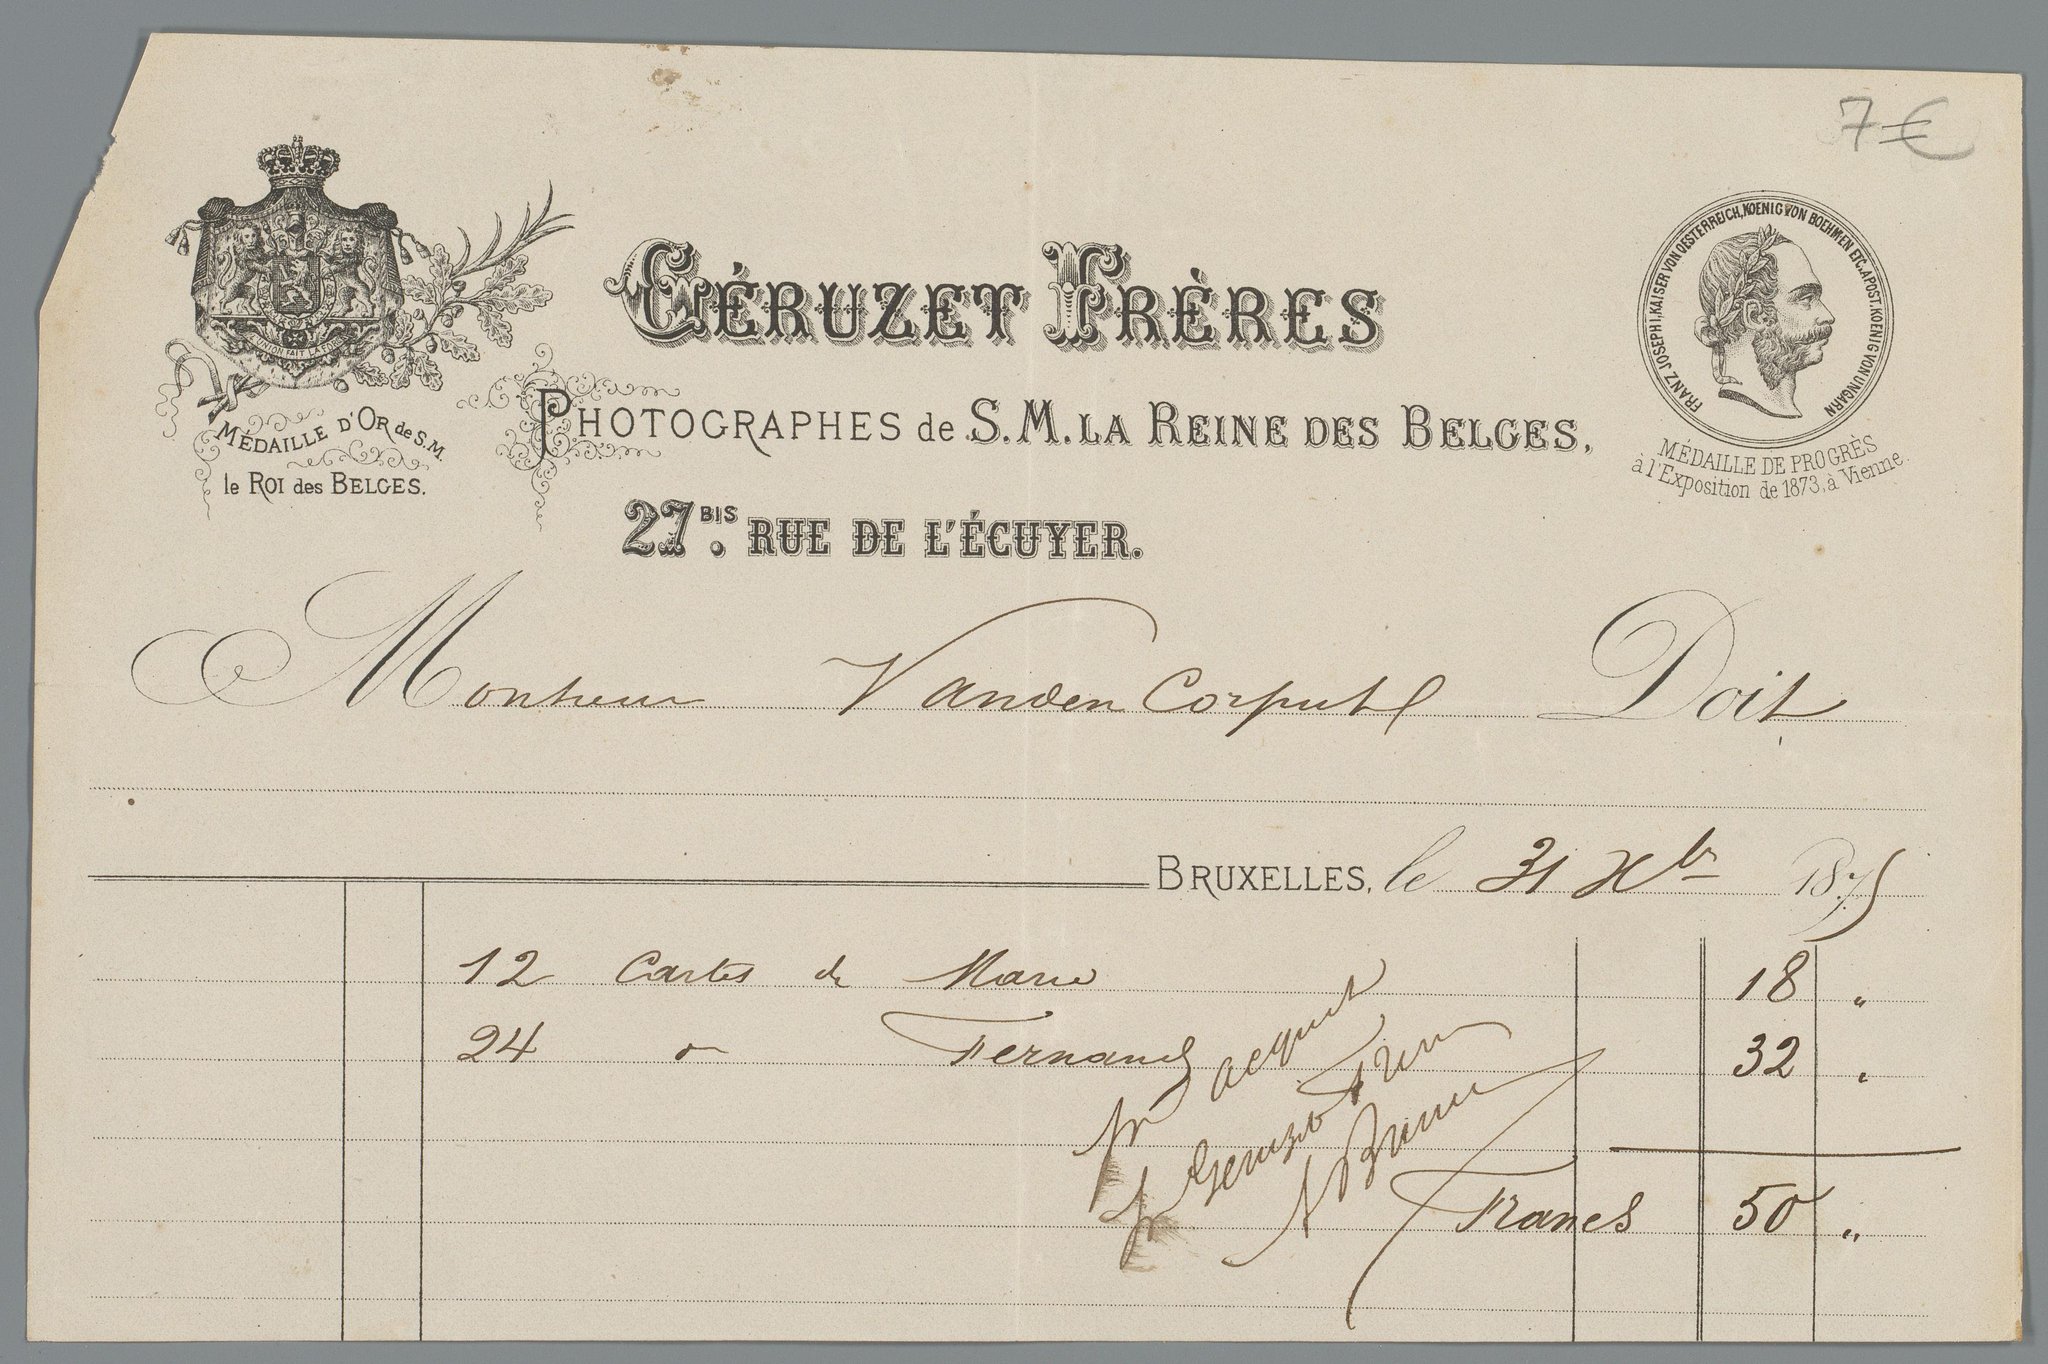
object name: account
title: Nota van de firma Géruzet Frères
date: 1875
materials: ink, paper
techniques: pen, printing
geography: brussels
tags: photography, cheque, draft, bill of exchange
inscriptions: inscription: ‘7 €’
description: Nota van de firma Géruzet Frères gericht aan de heer Vanden Corput, gedateerd op 31 december 1875 te Brussel.